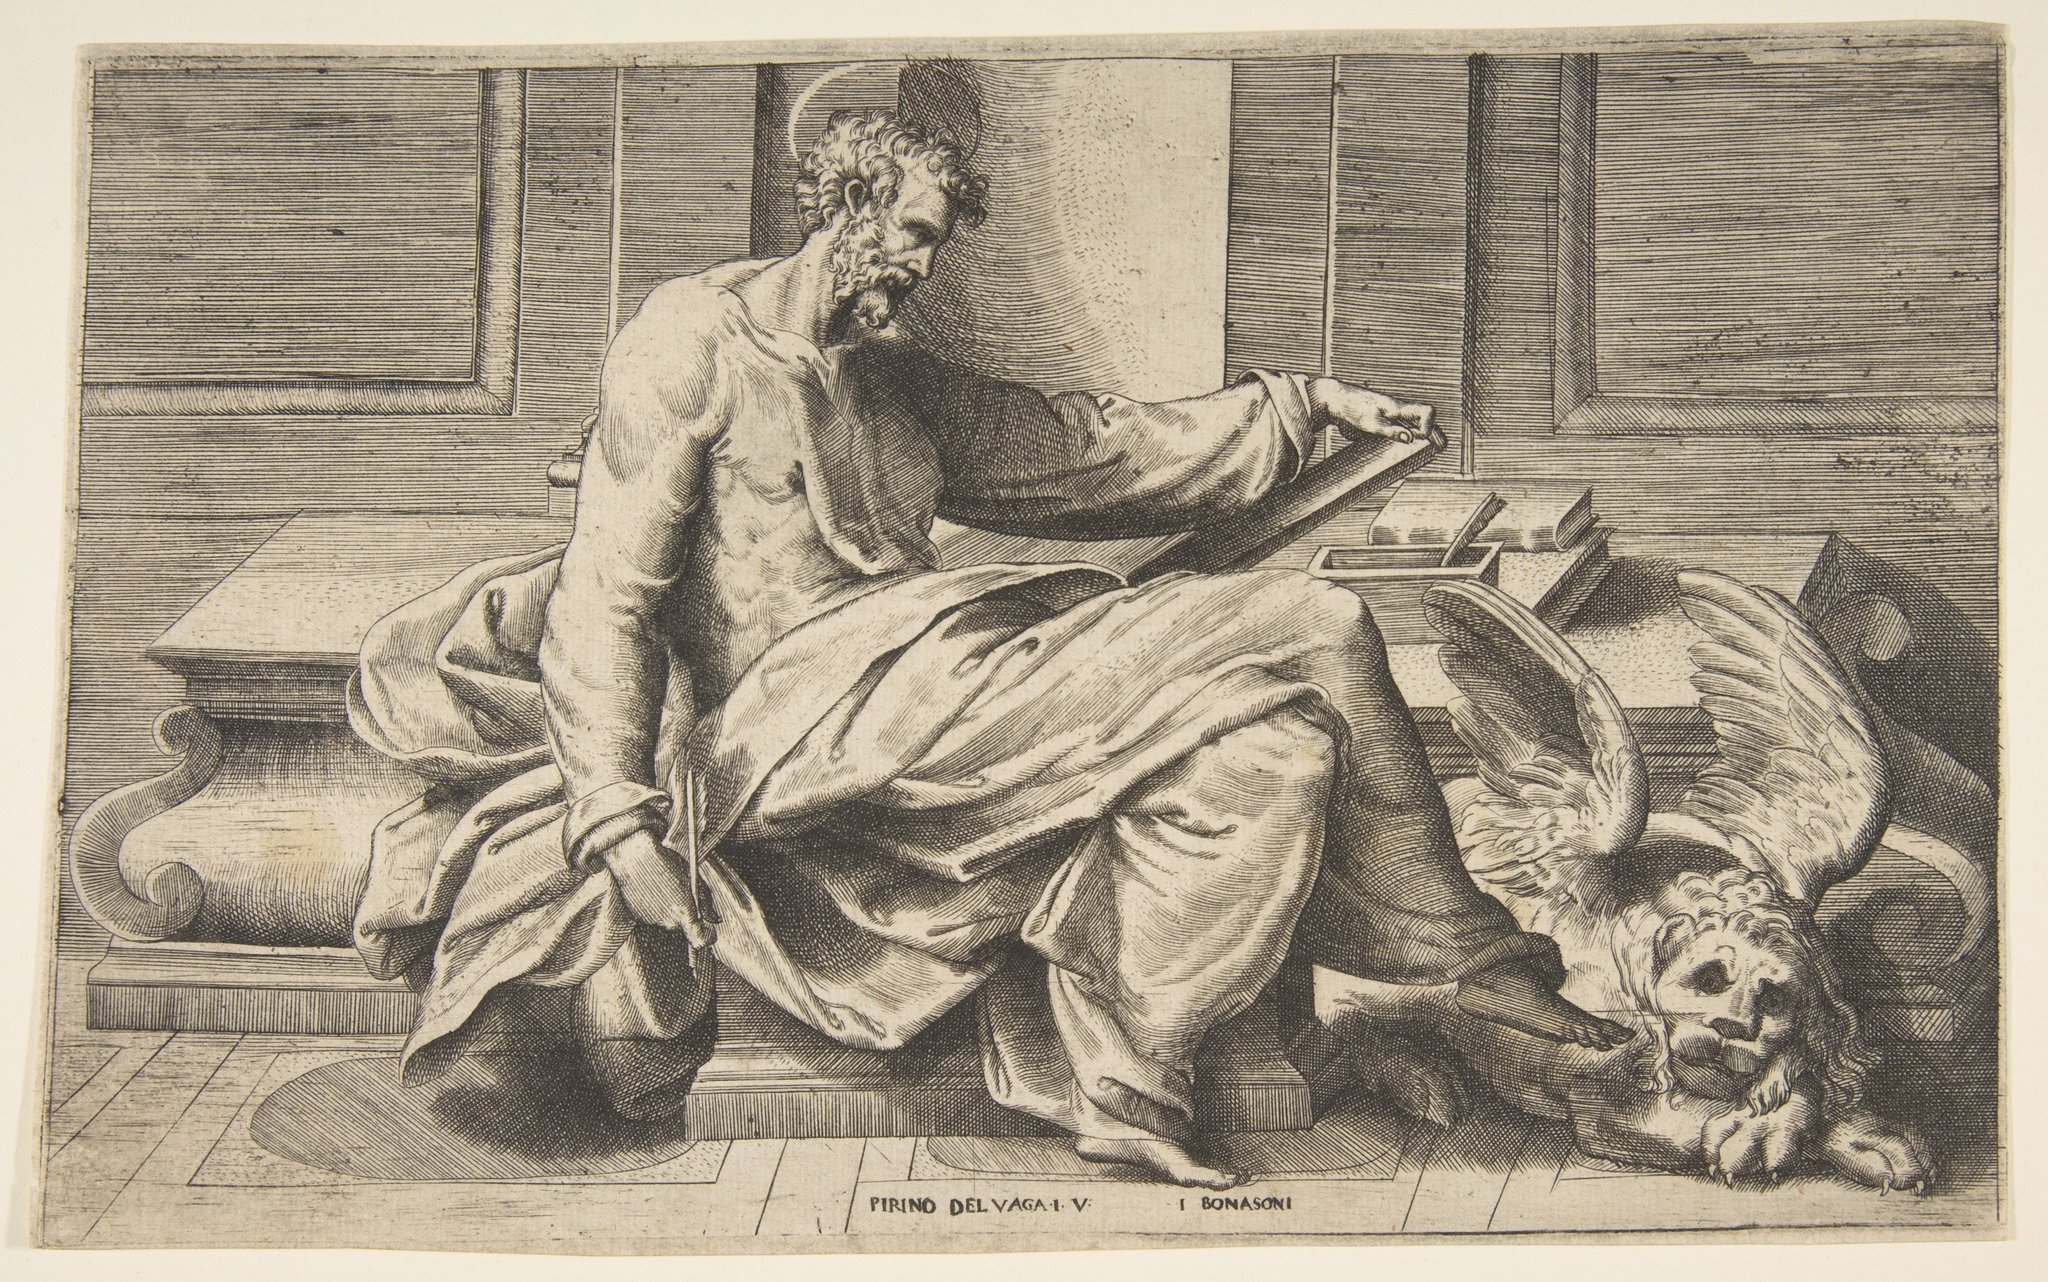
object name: print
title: Saint Mark writing his Gospel, a winged lion at the right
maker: giulio bonasone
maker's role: artist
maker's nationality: italian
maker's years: 1510-1576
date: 1531-1576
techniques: engraving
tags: saint mark,writing